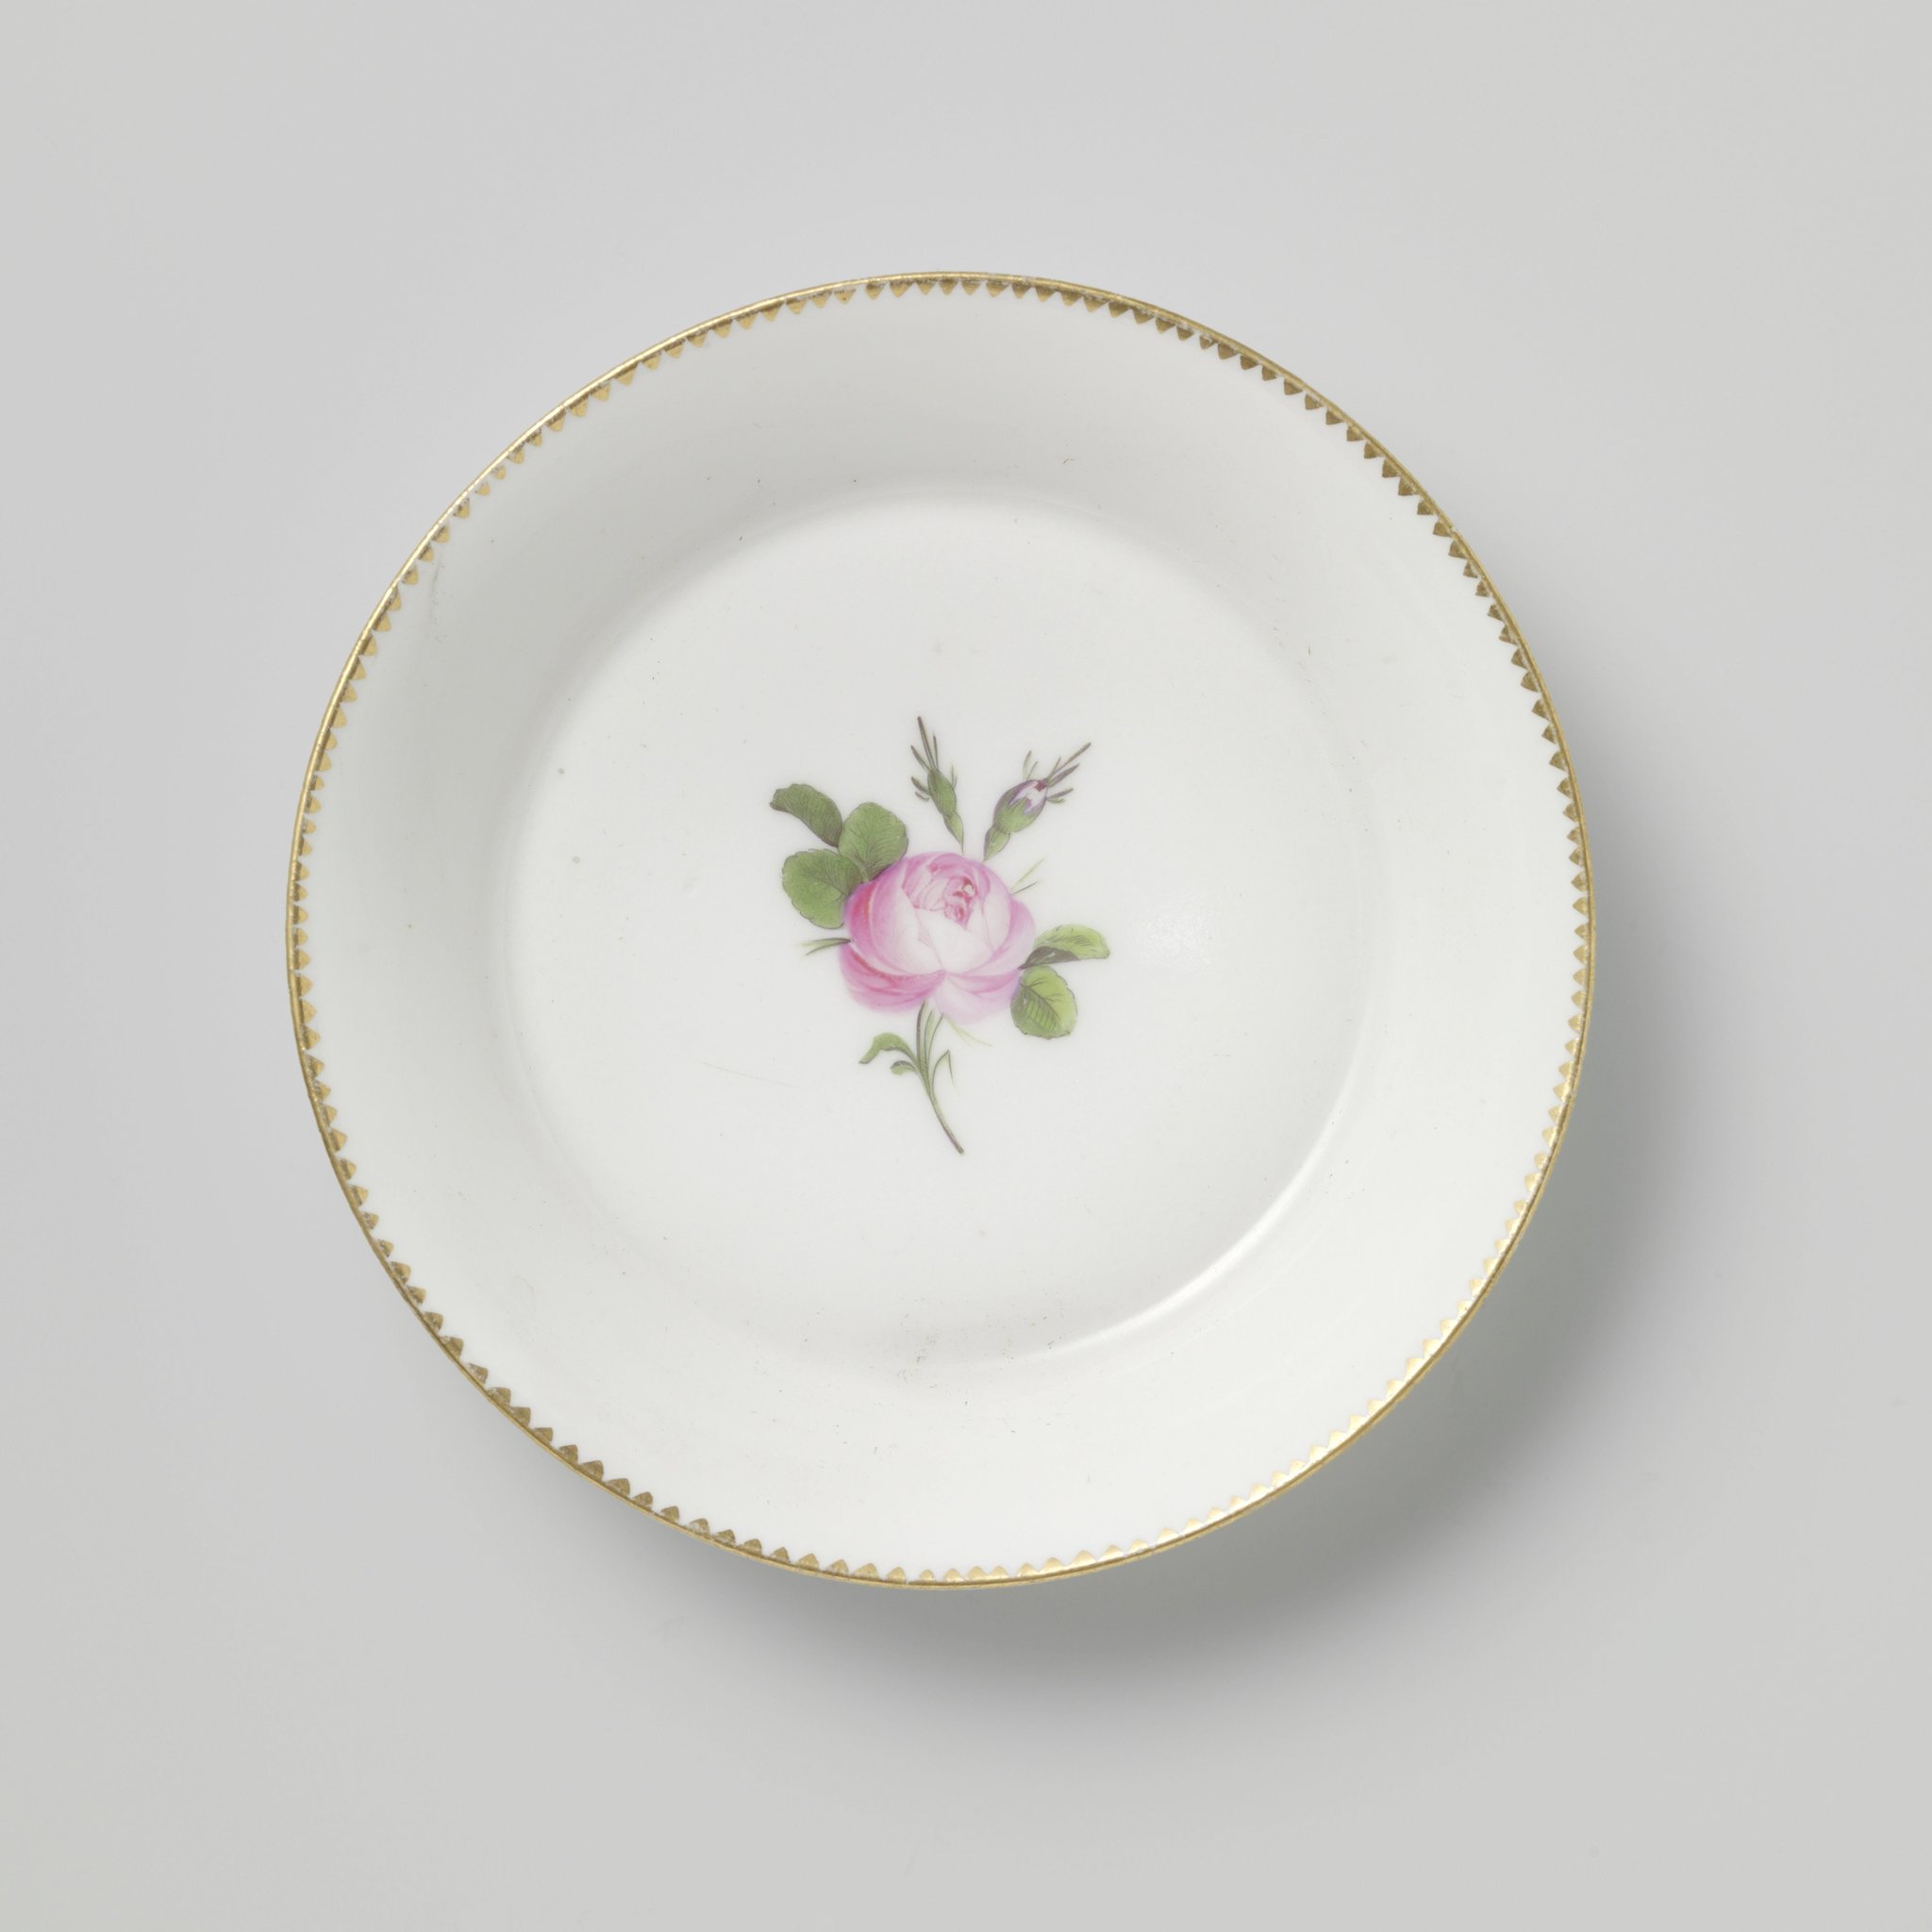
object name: platter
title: Saucer with a flower spray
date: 1775-1790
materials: glaze, gold, paint, porcelain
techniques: firing, gilding, turning, vitrification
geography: clignancourt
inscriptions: mark: ‘LSX’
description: Schotel van porselein met een cilindrische wand en oor, beschilderd op het glazuur met roze, groen, geel, zwart en goud. Op het plat een bloemtak (roos). Gouden rand. Gemerkt op de onderzijde met het monogram 'LSX'.